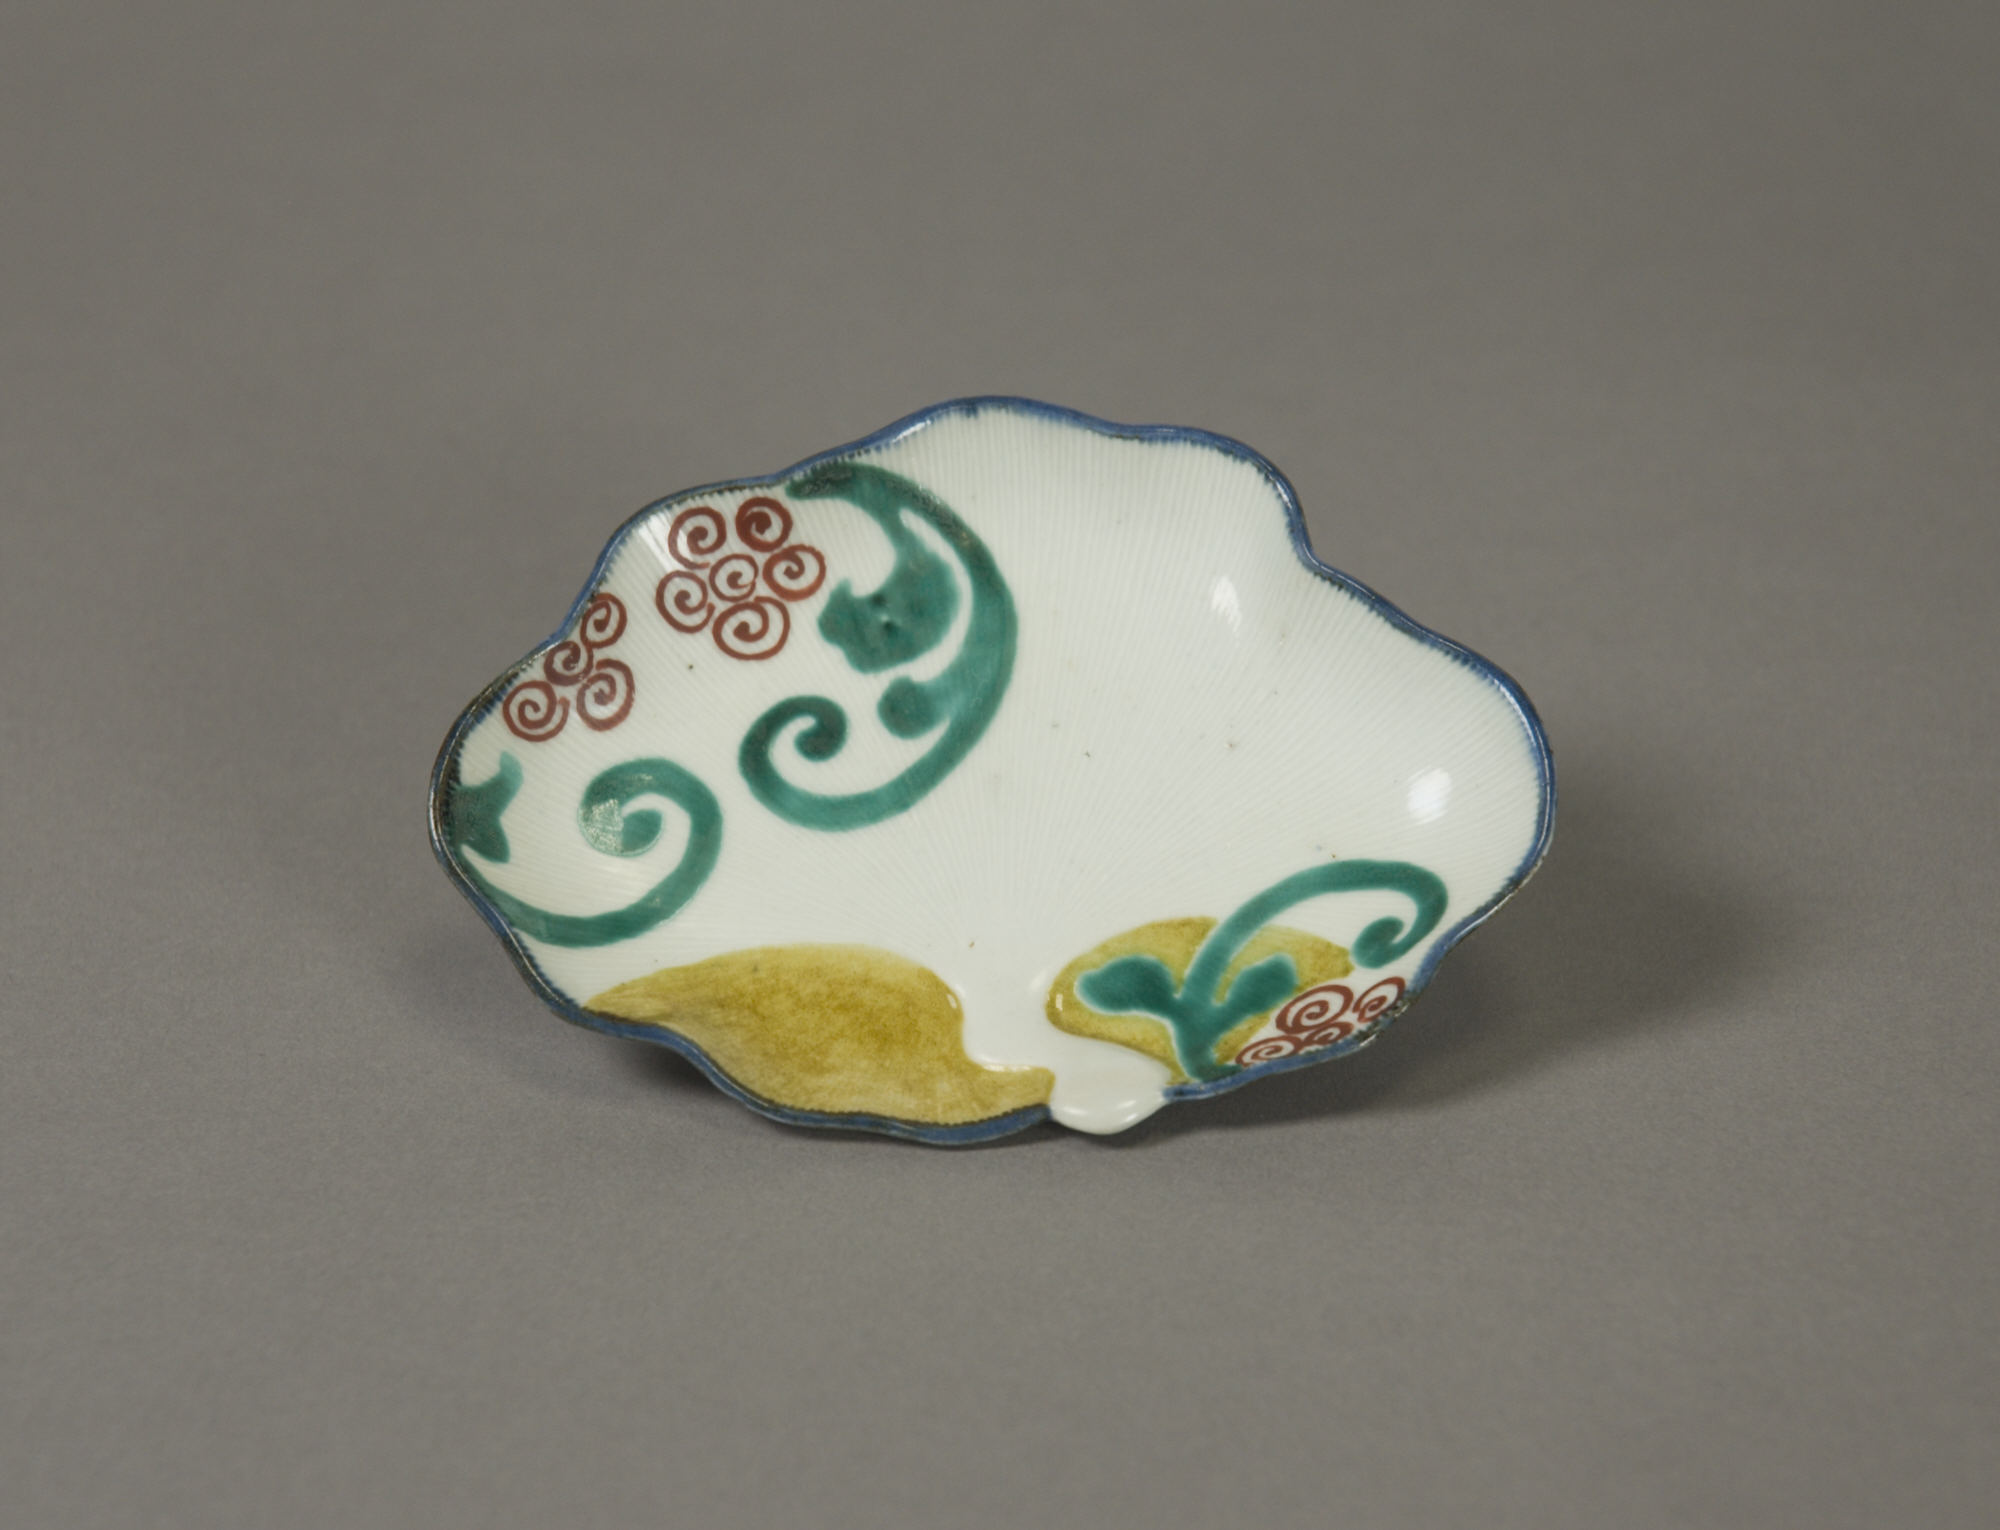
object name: dish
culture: japanese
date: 1667-1700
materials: enamel, porcelain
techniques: overglaze